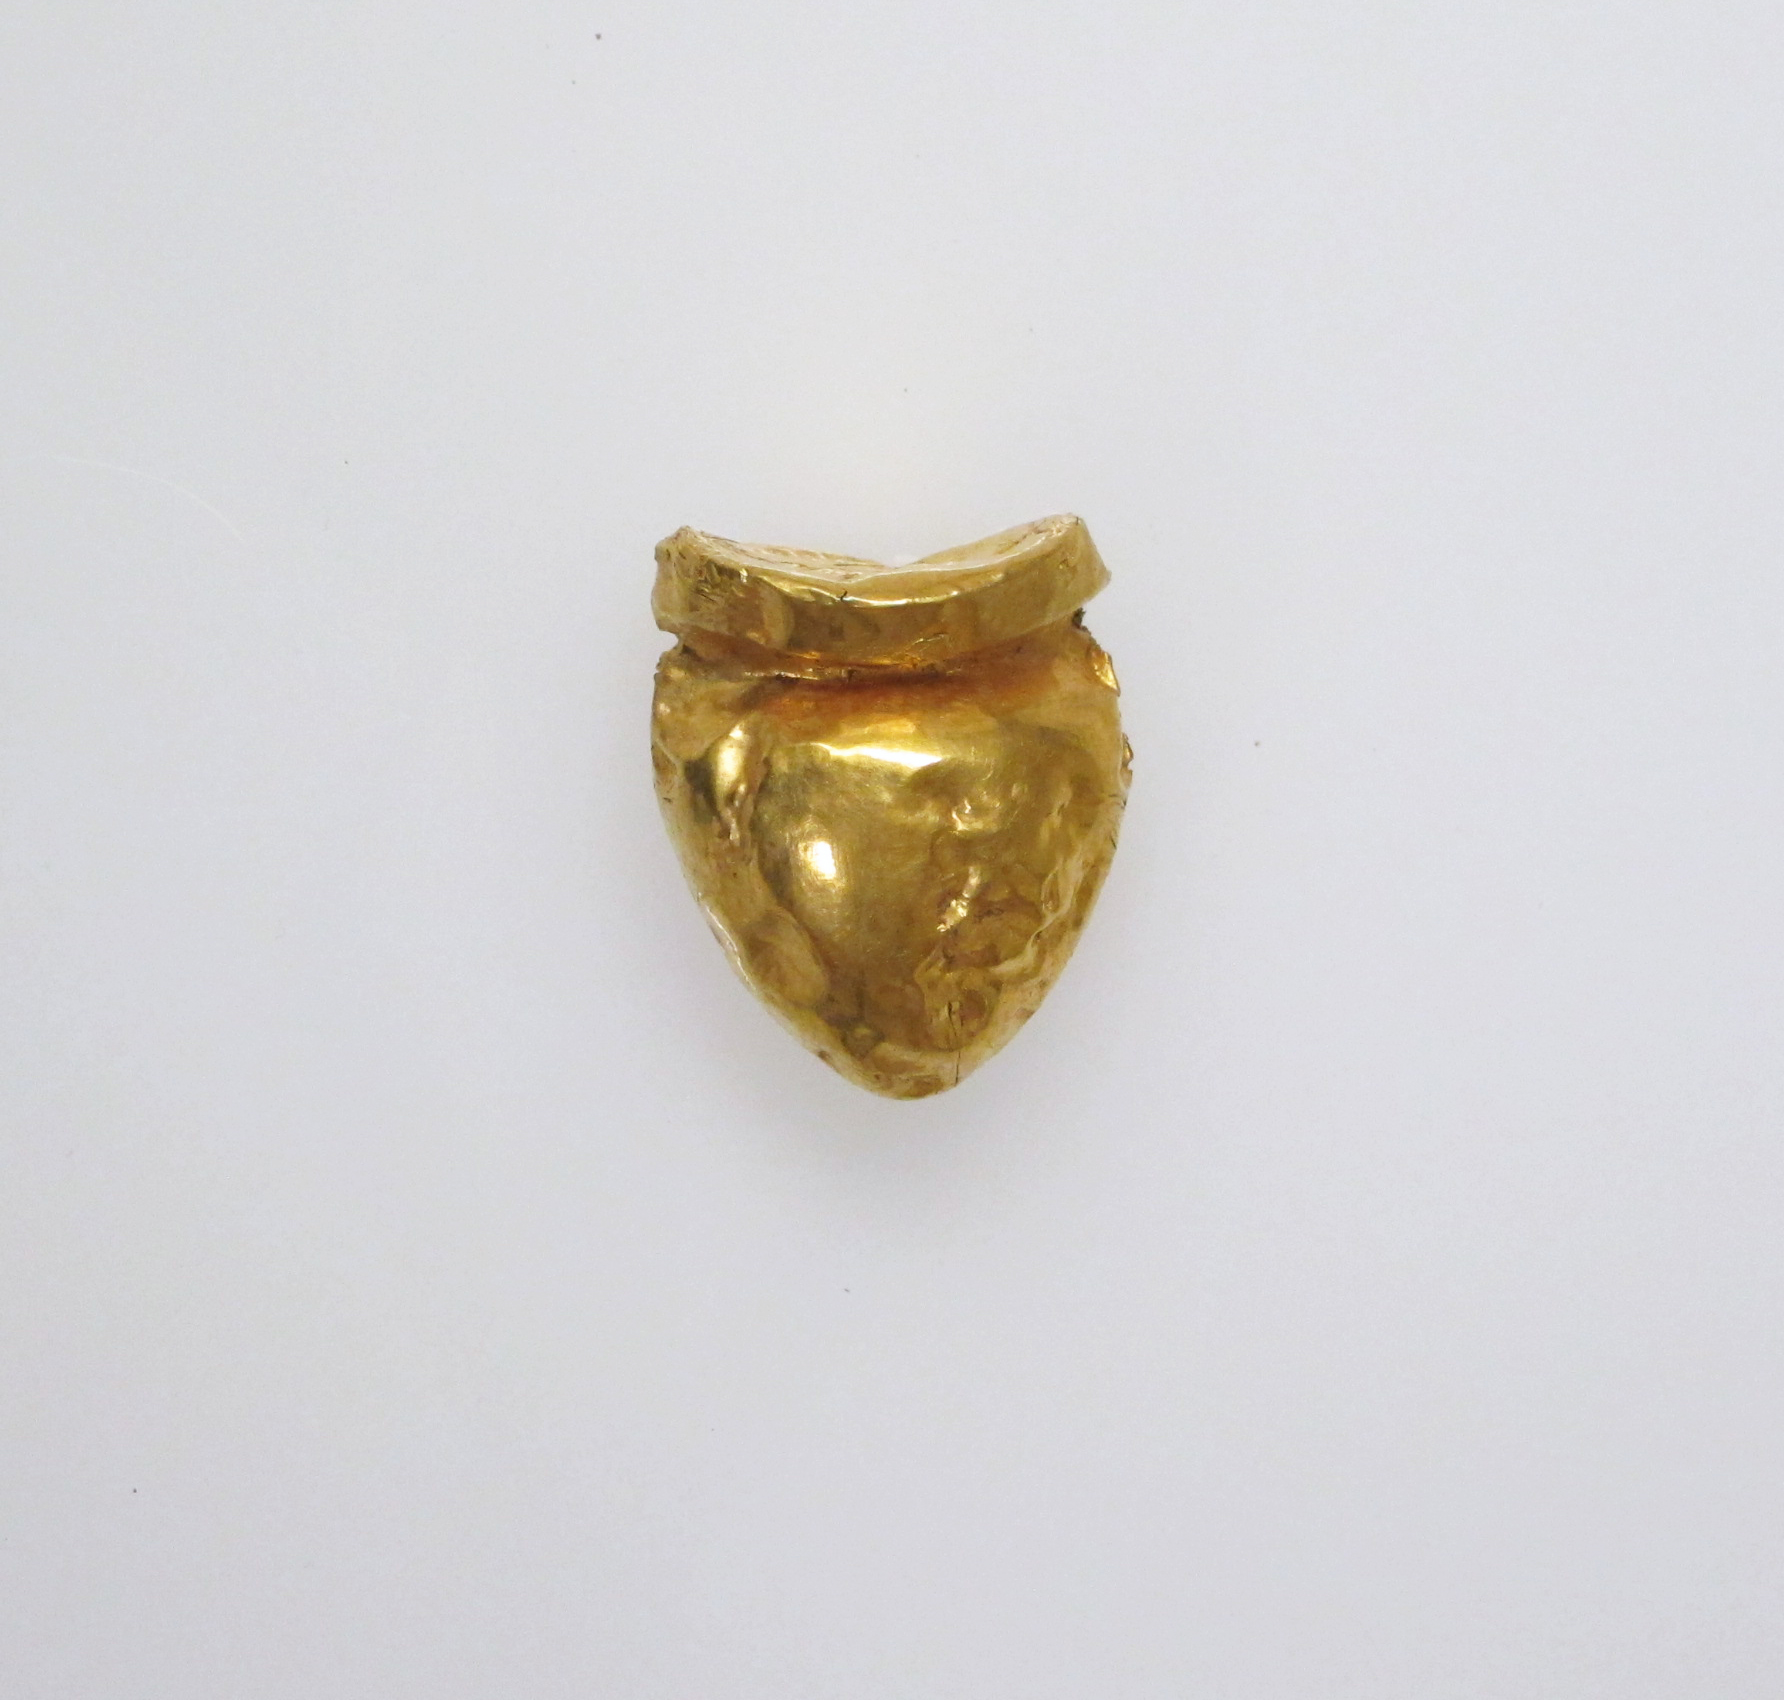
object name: rattle in the form of a heart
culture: greek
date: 600-501 BCE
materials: gold foil